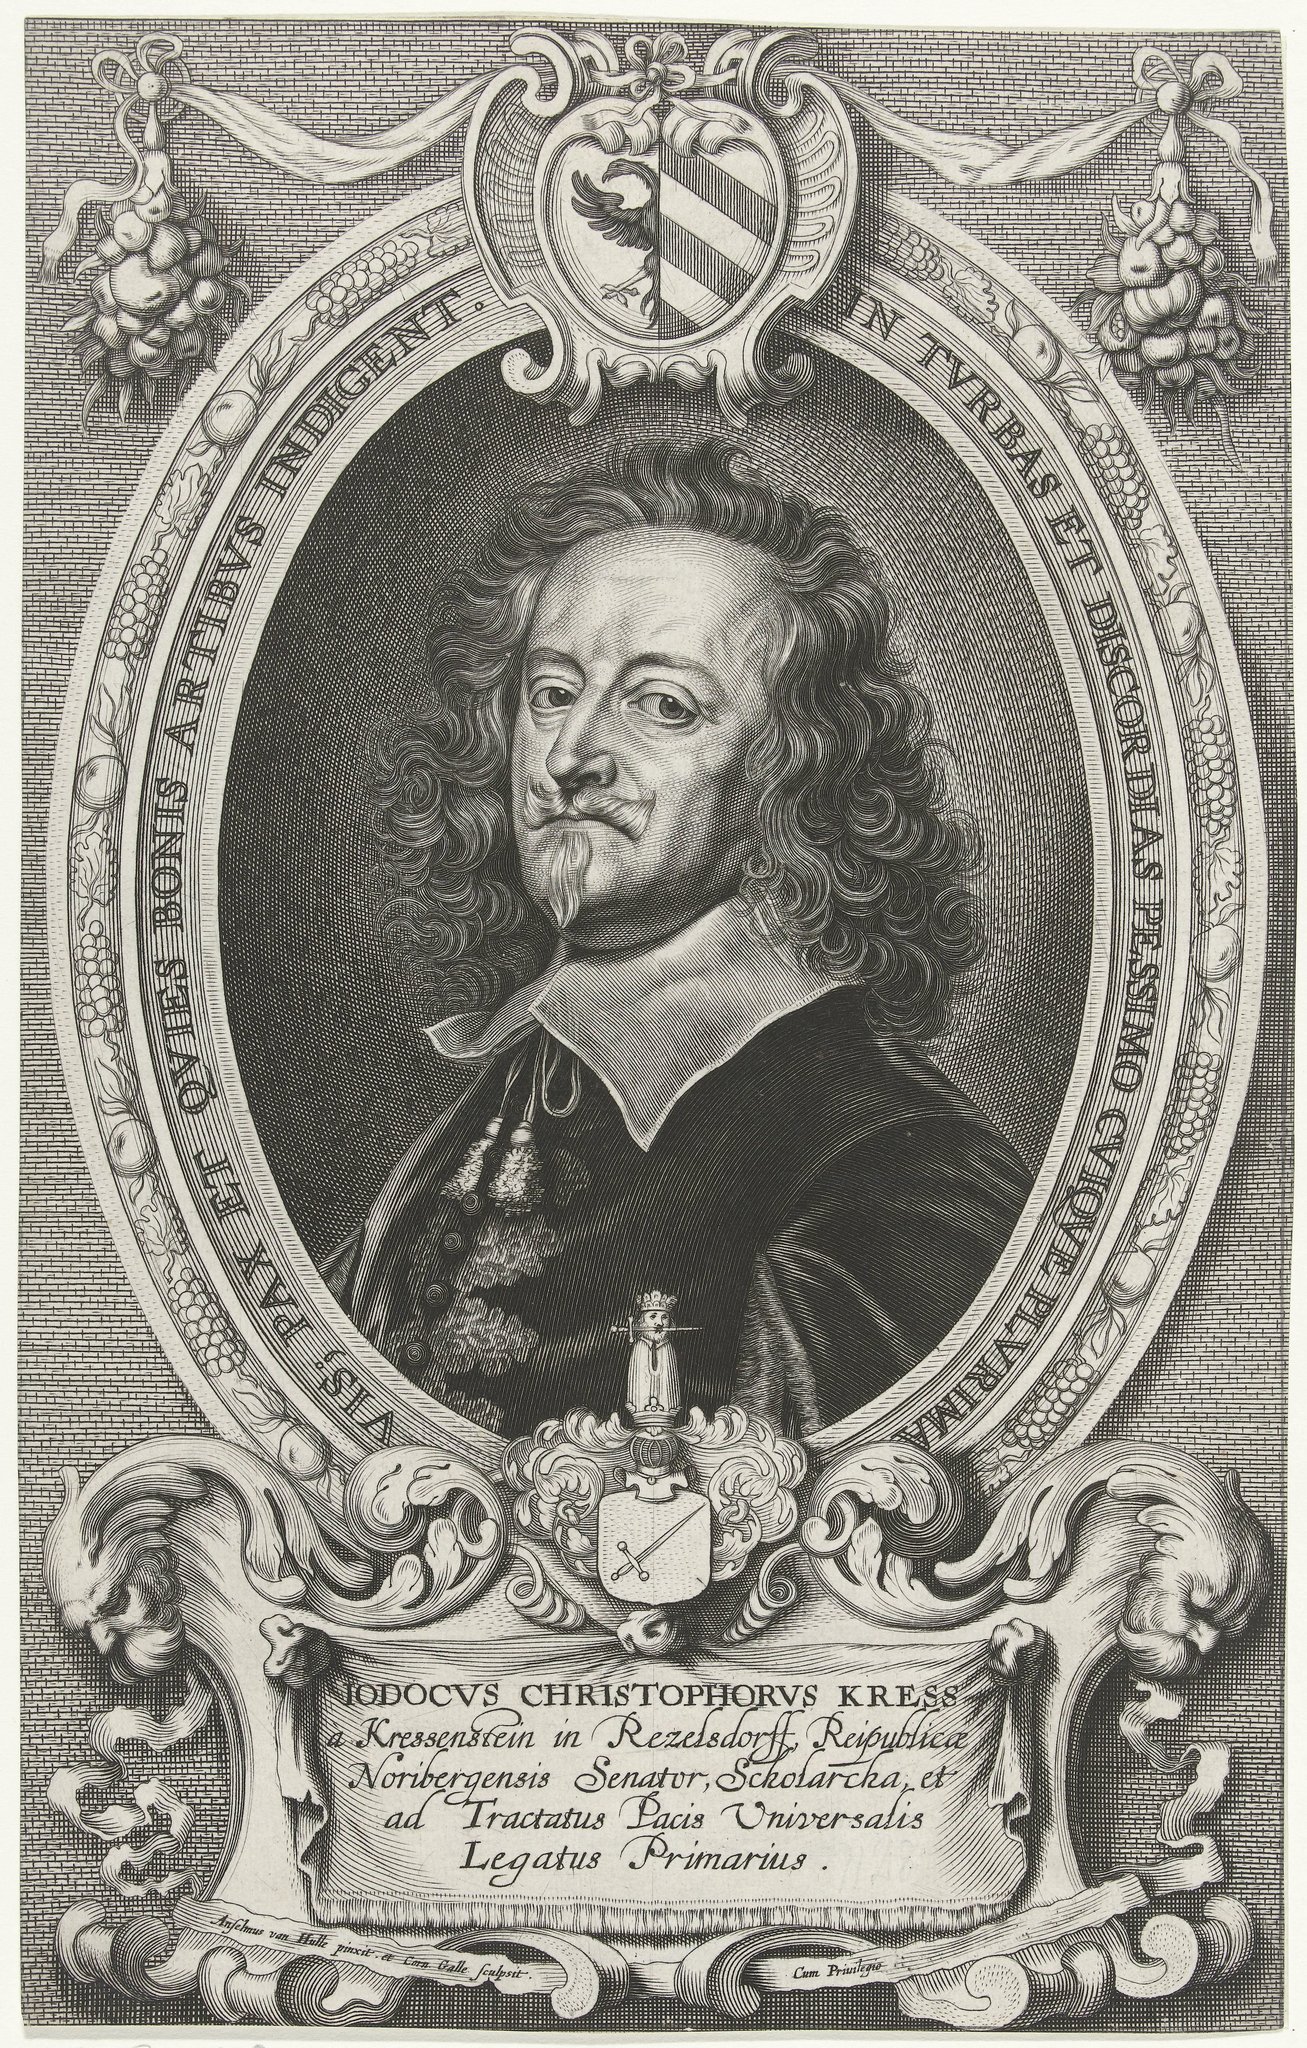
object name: print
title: Portret van Jobst Christoph Kress von Kressenstein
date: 1649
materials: paper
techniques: engraving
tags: neurenberg, diplomaat, raadsheer, afgezant, jobst christoph kress von kressenstein (i)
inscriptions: collector's mark: ‘P. Mariette 1674’ Lugt 1789, collector's mark: Lugt 2228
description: Portret van Jobst Christoph Kress von Kressenstein, in ovaal met randschrift. Boven het portret het wapen van Neurenberg, onder het familiewapen van Kress von Kressenstein.